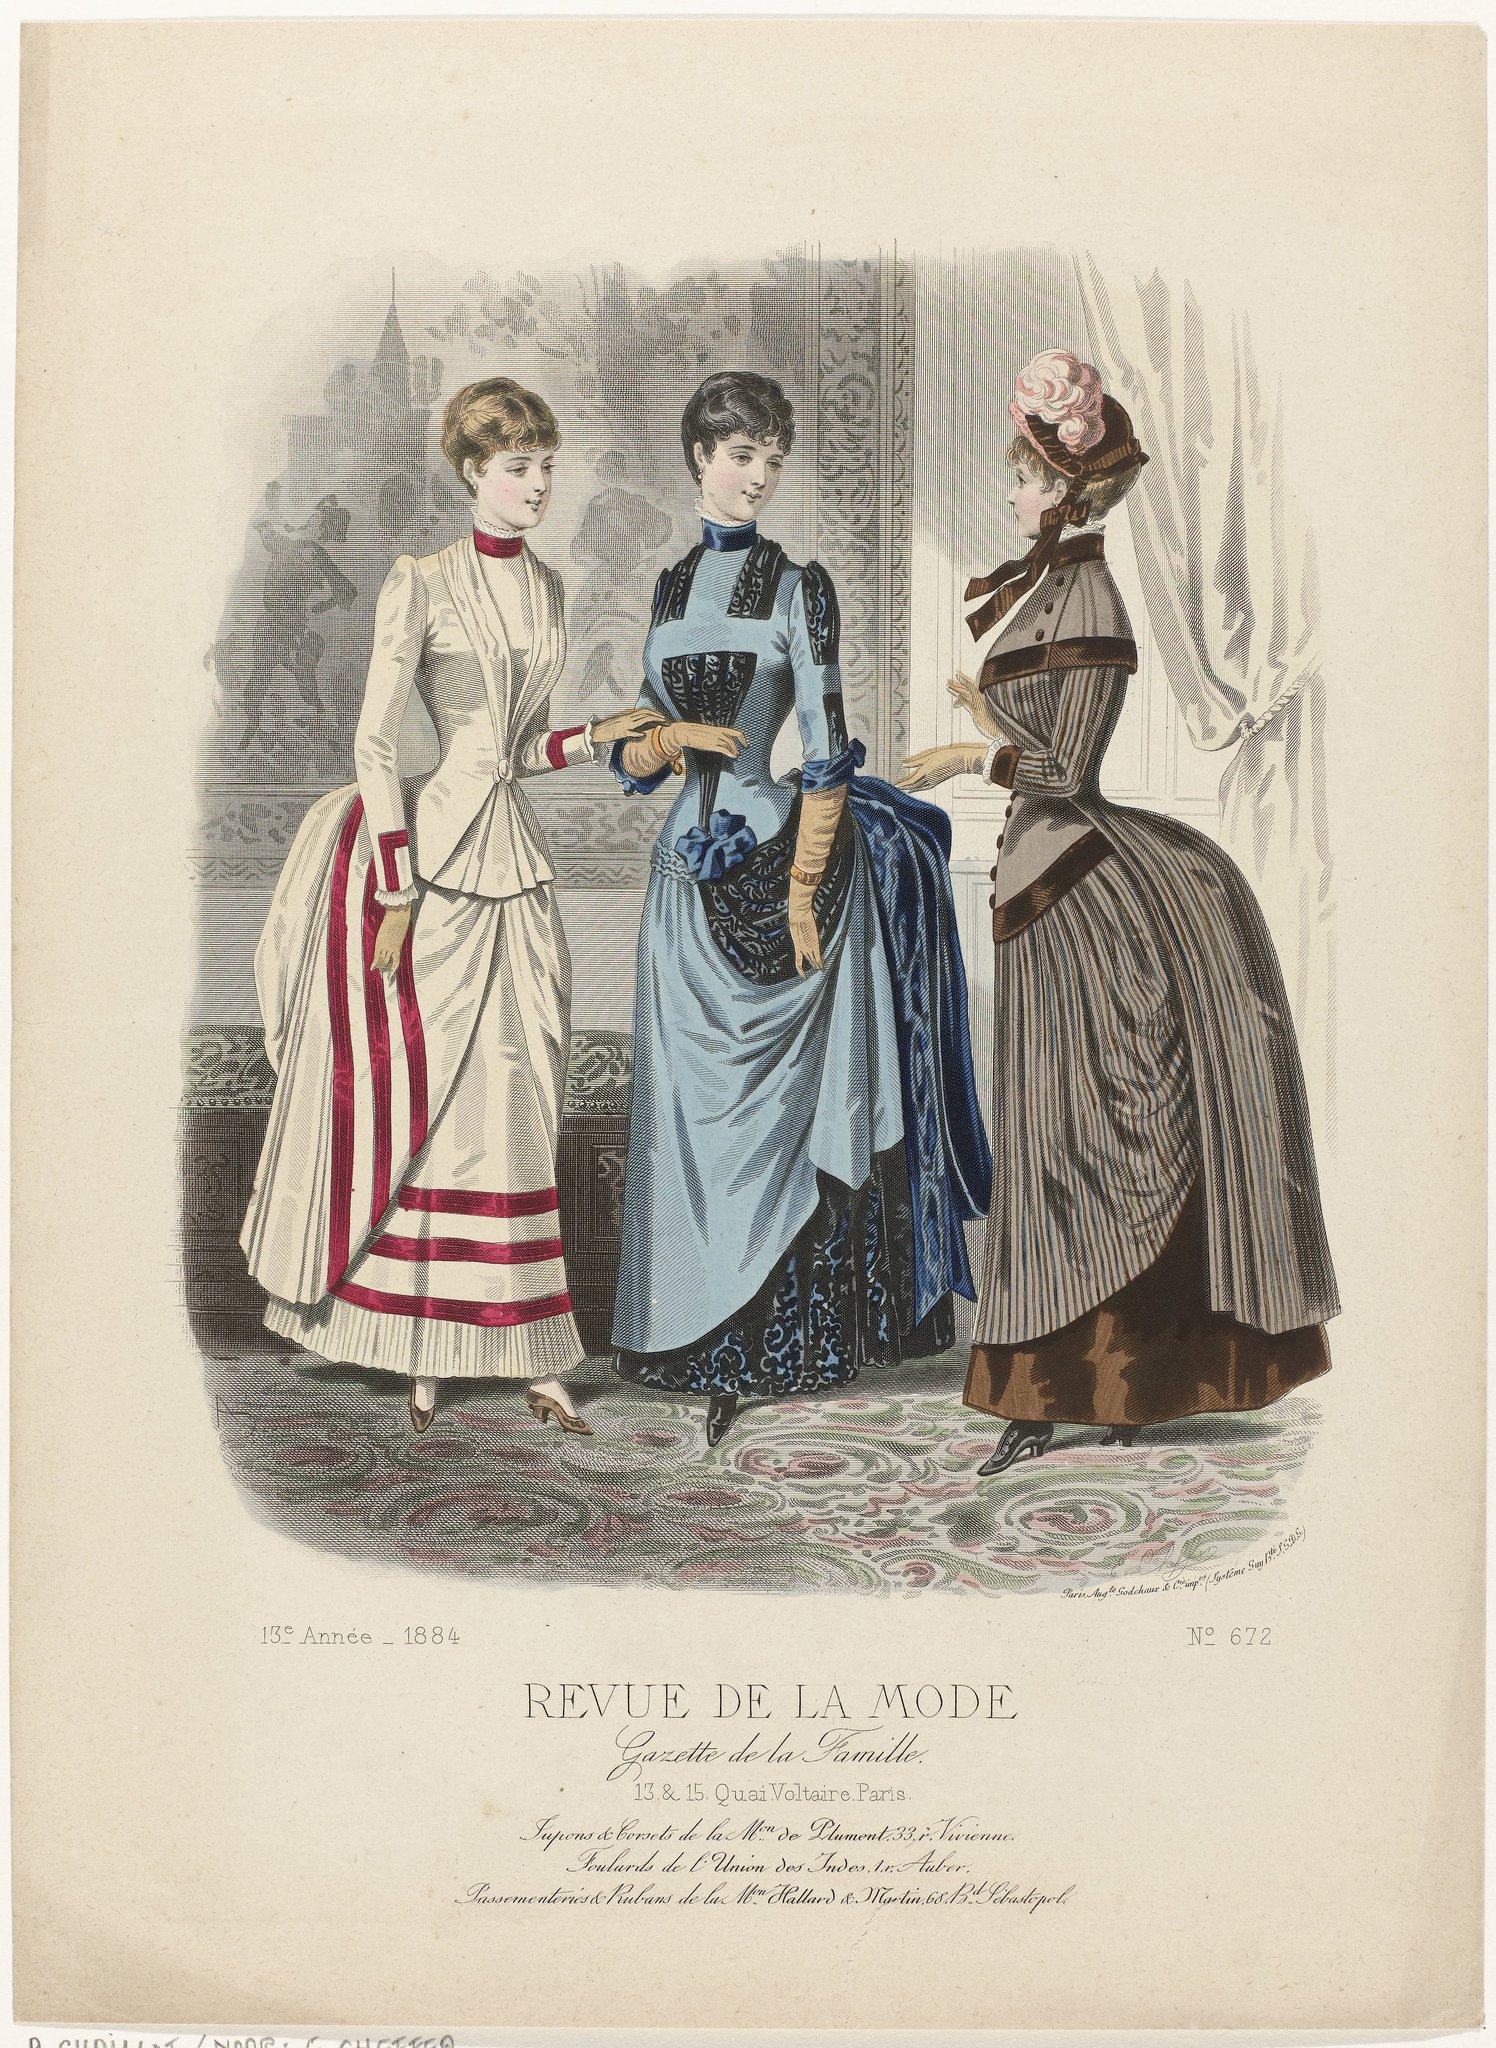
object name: fashion print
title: Revue de la Mode, Gazette de la Famille, dimanche 16 novembre 1884, 13e Année, No. 672: Jupons & Corsets (...)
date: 1884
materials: paper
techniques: engraving, hand coloring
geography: paris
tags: clothing for the upper part of the body (+ women's clothes), gloves, mittens (long gloves) (+ women's clothes), border, ribbon, braid (+ women's clothes), lace (+ women's clothes), clothing for the upper part of the body (mantelet) (+ women's clothes), fashion plates, head-gear: hat (+ women's clothes), skirt (+ women's clothes), bracelet, wristlet (+ women's clothes)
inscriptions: title: ‘REVUE DE LA MODE / Gazette de la Famille’, caption: ‘Jupons & Corsets de la M.on de Plument, 33, r. Vivienne. Foulards de l'Union des Indes, 1,r. Auber. Passementeries & Rubans de la M.on Hallard & Martin, 68, B.d Sébastopol.’, address: ‘13 & 15, Quai Voltaire Paris’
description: Drie vrouwen in een interieur. Links: japon van crèmekleurige wol versierd met rode galons, geschikt voor een jonge vrouw. Midden: japon van grijs satijn, zwart kant en lint van 'moire'. Rechts: jpon van grijs gestreepte wol en bruin fluweel. Pelerine, dichtgeknoopt aan de linkerkant, van effen grijze stof gegarneerd met een biais van bruin fluweel. Met enkele regels reclametekst voor verschillende producten. Prent uit het modetijdschrift Revue de la Mode (1872-1913). Uitgebreide beschrijving van de kleding op pagina 366 "PLANCHE COLORIÉE".